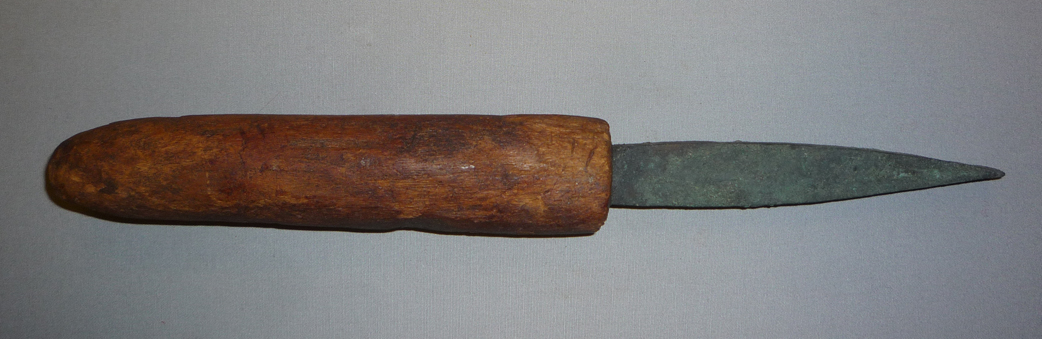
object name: chisel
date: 1479-1458 BCE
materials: bronze, copper alloy, wood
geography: egypt